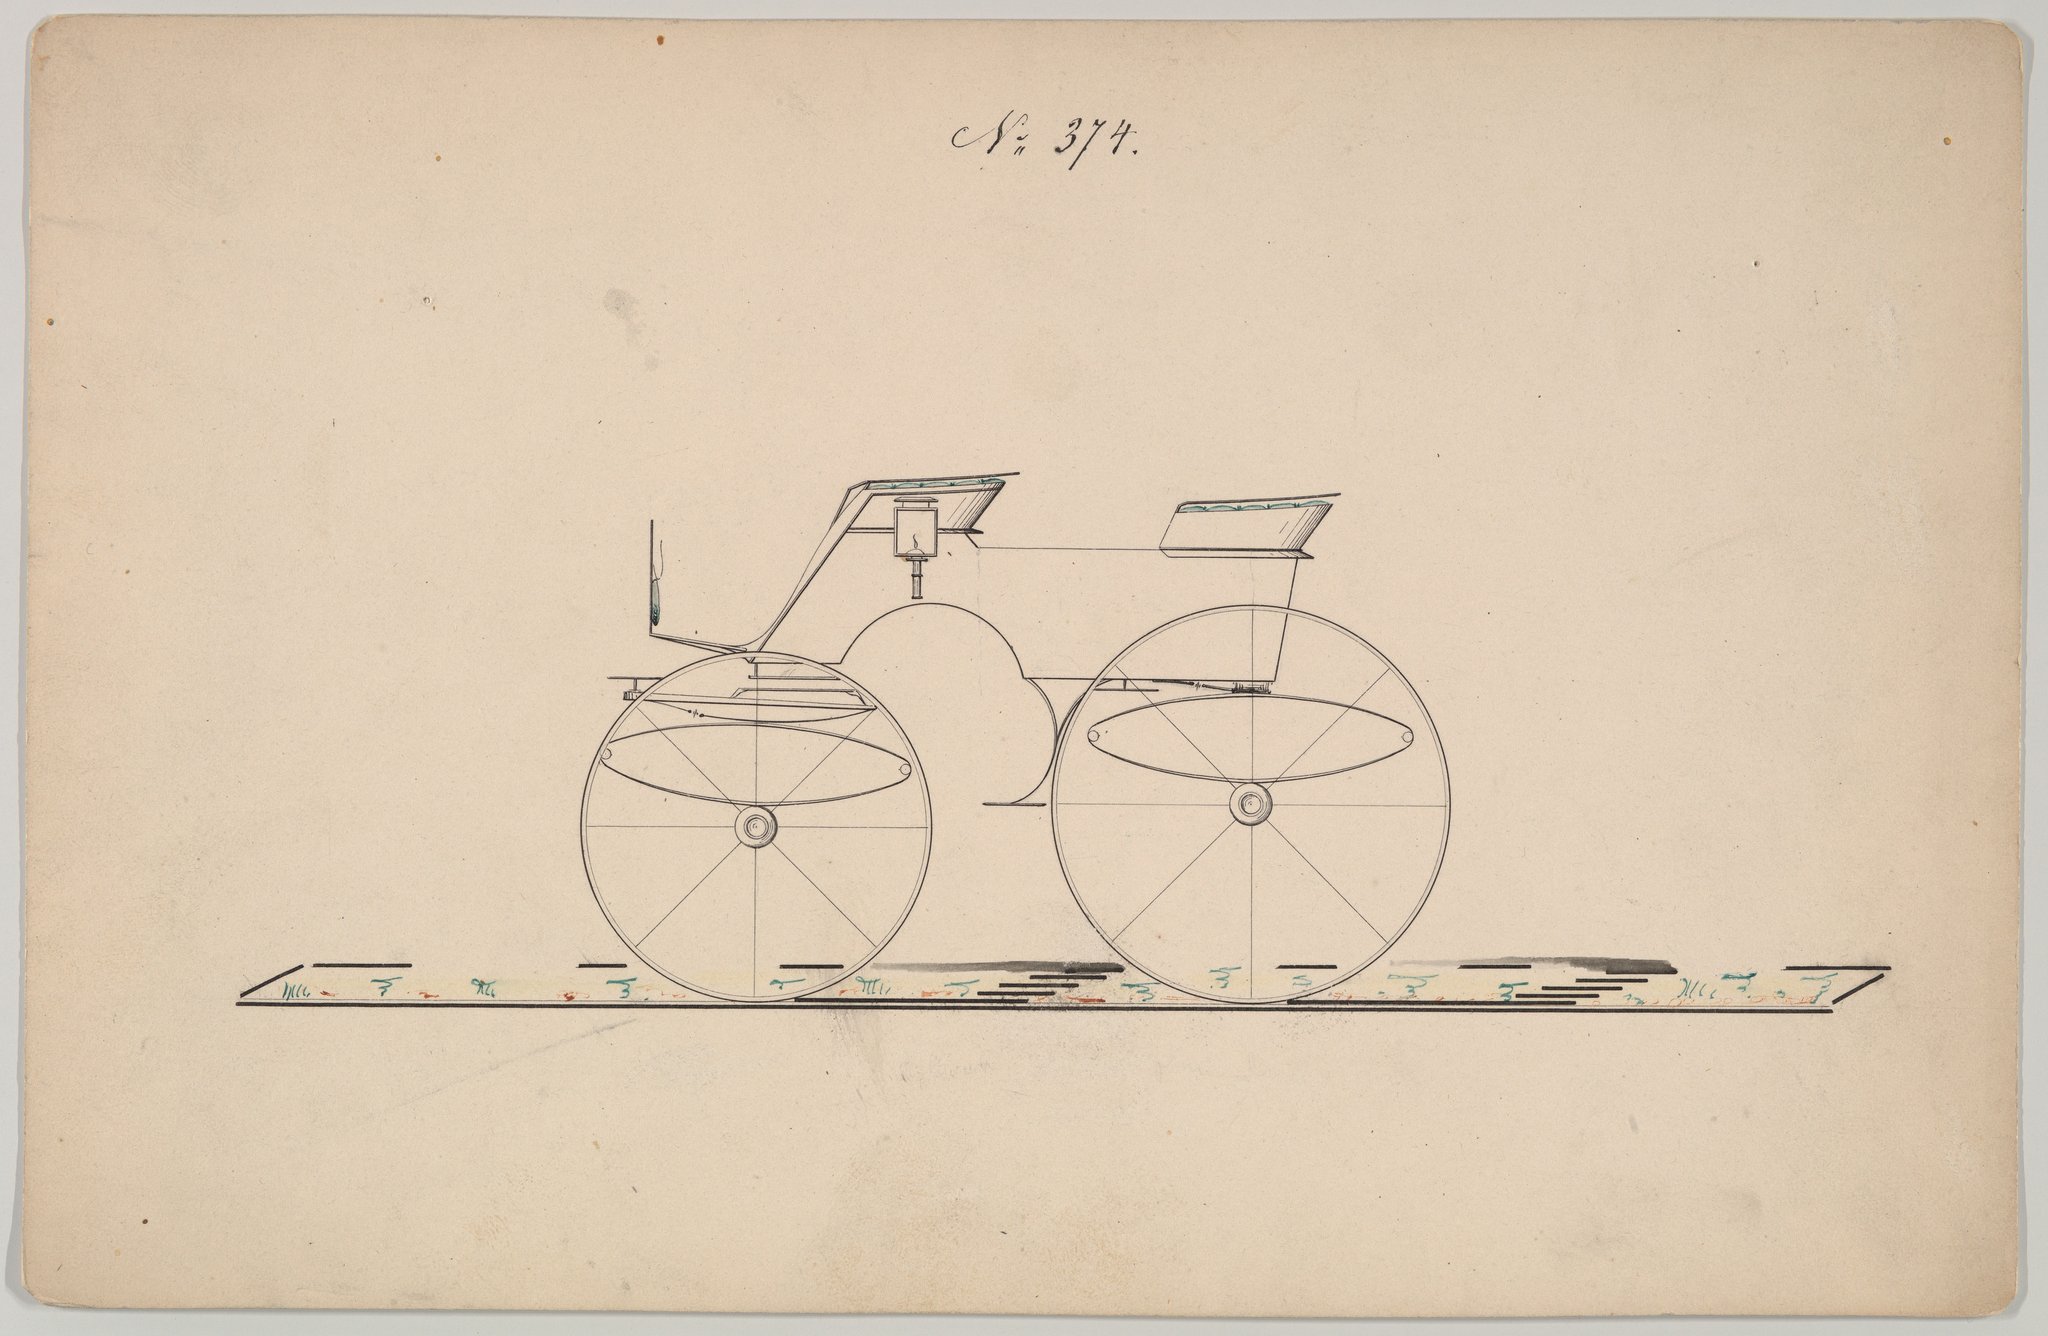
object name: drawing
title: Dog Cart Phaeton #374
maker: brewster & co.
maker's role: manufacturer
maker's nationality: american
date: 1850-1870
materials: gouache, ink, watercolor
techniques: pen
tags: carriages